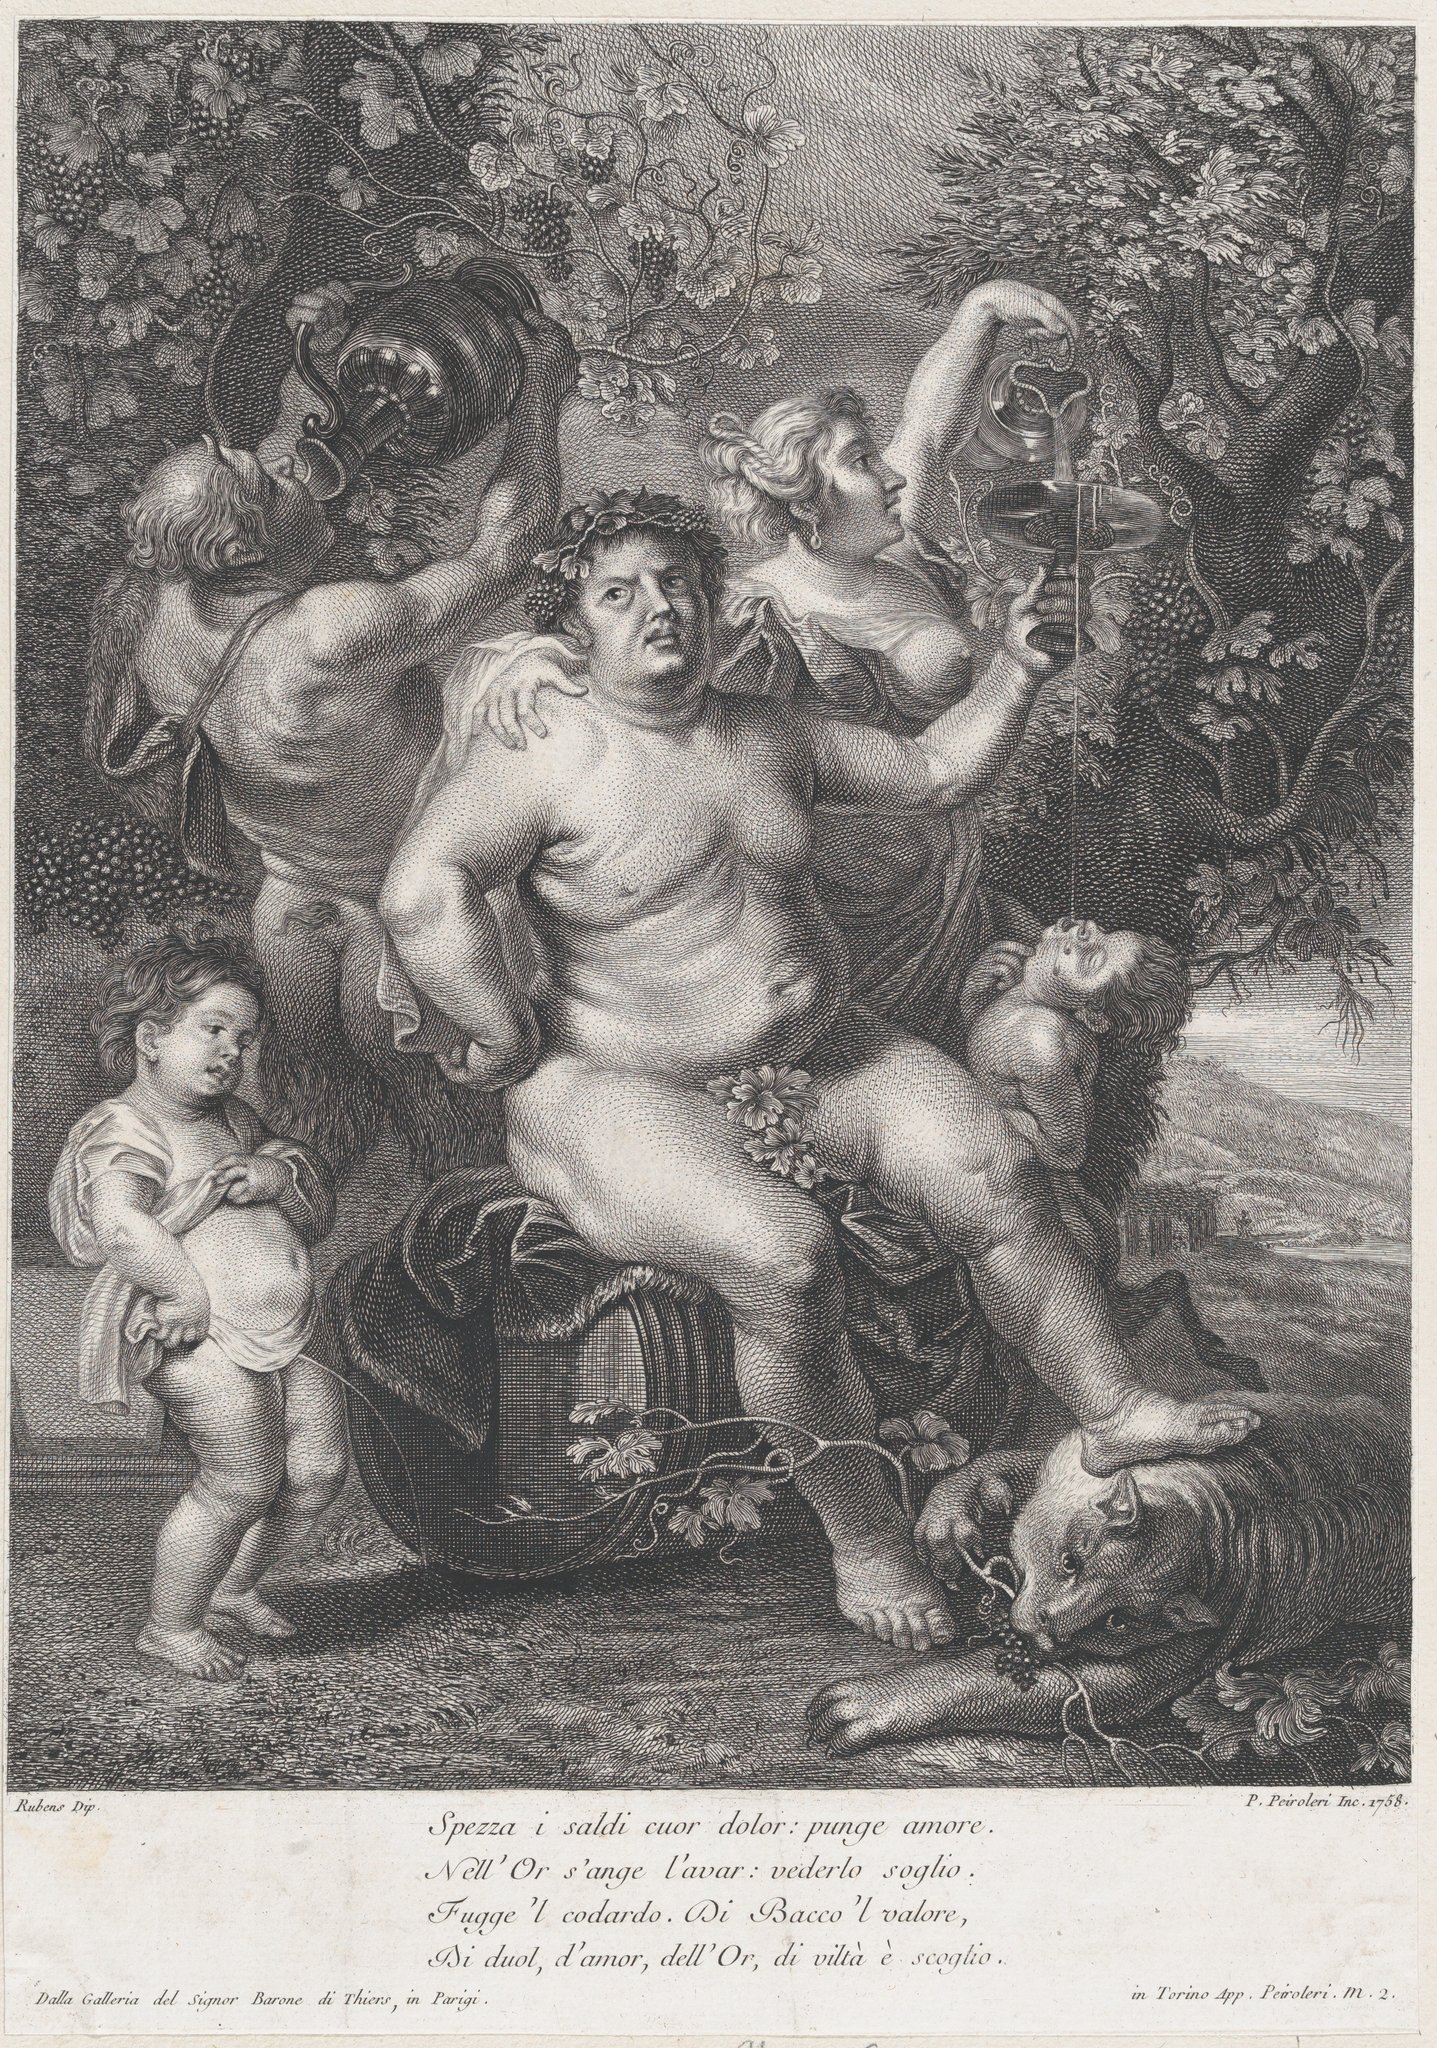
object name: print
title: Bacchus seated on a barrel in front of grapevines, with bacchantes, satyrs, and children surrounding him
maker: pietro peiroleri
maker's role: artist and publisher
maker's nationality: italian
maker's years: 1741-1841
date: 1758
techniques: engraving, etching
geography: turin